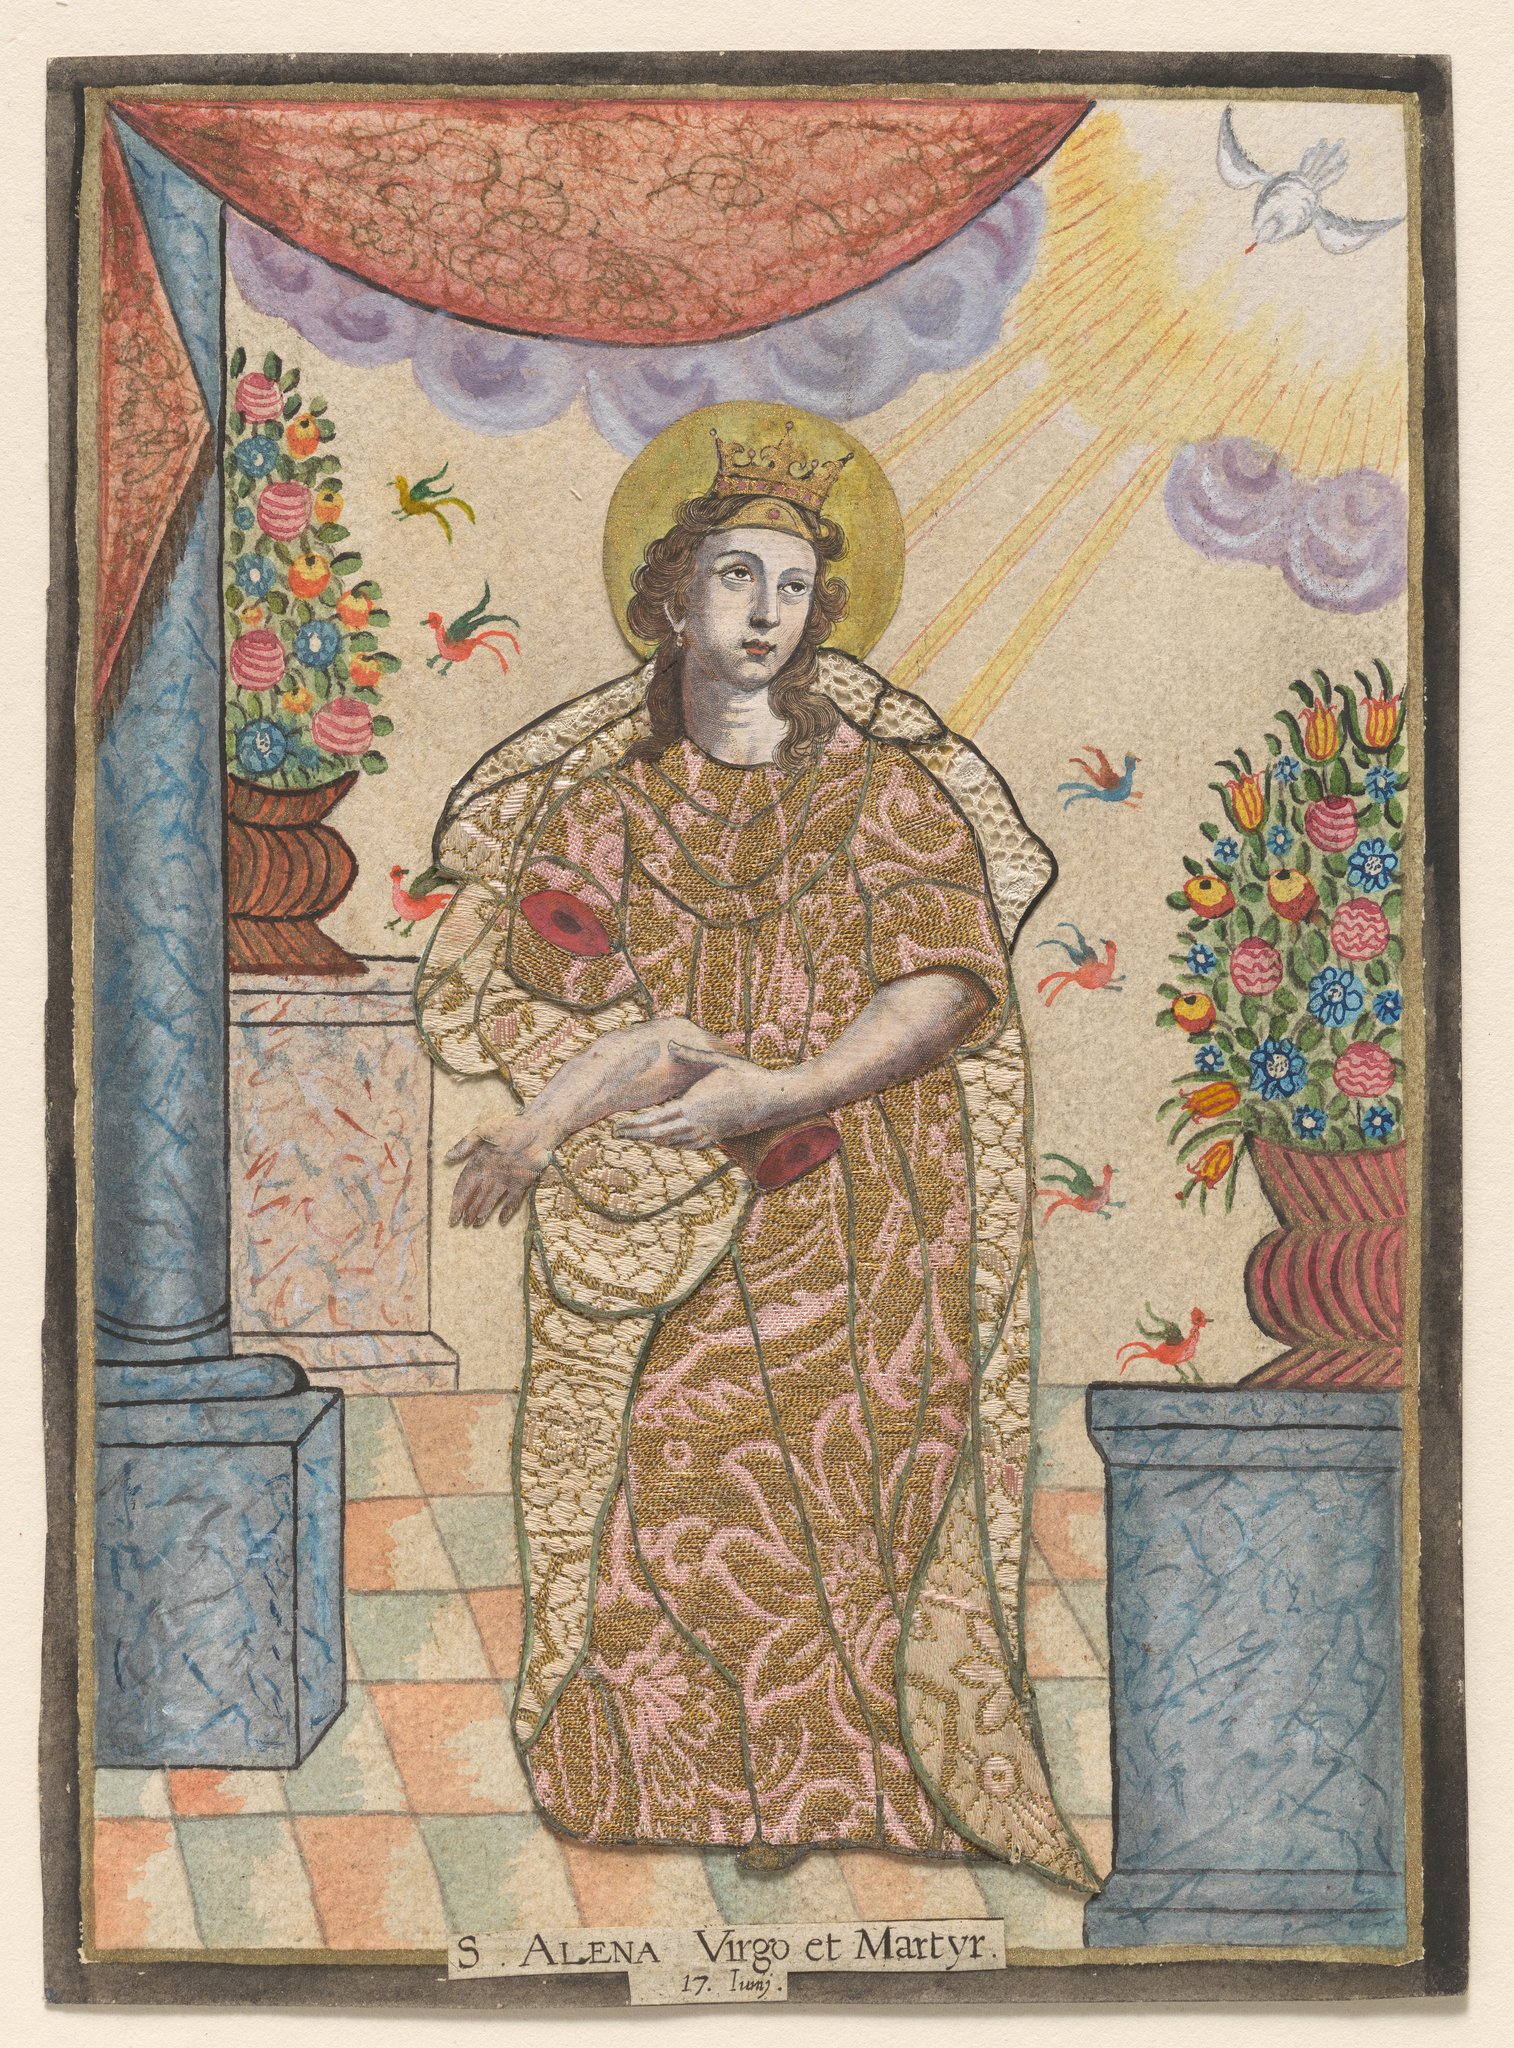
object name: cut paper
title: Saint Alena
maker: anonymous, 18th century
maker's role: artist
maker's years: 1700-1800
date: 1701-1800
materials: lace, paint, paper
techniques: engraving, hand coloring